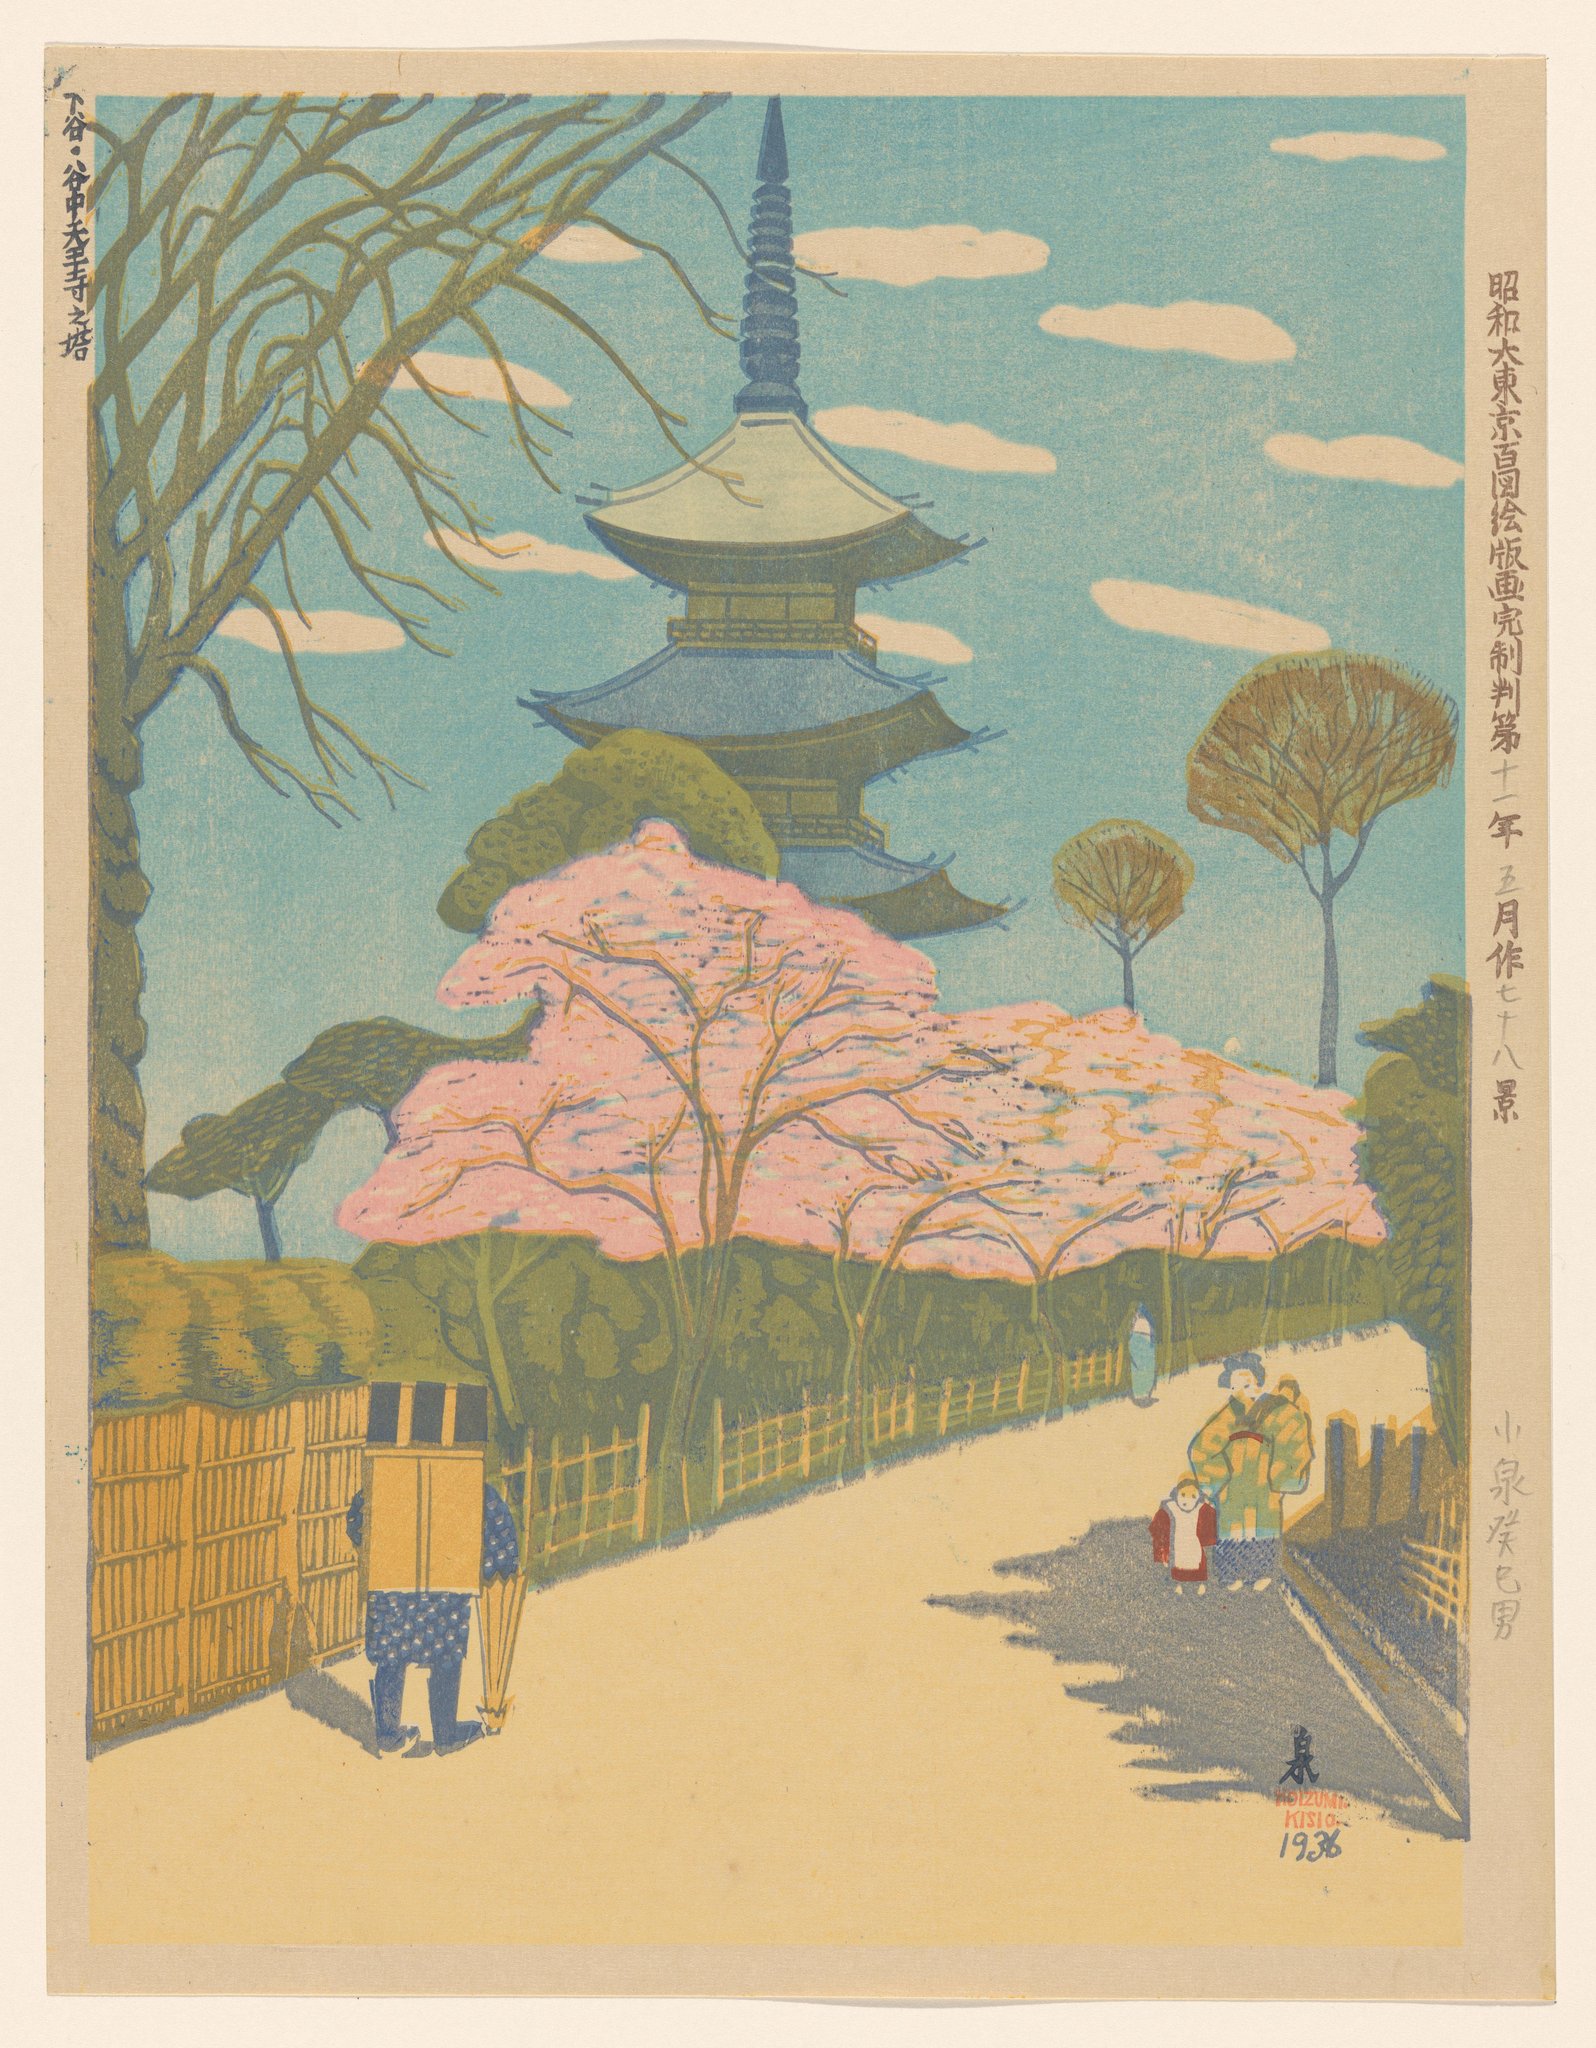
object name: print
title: Shitaya Yanaka Tennōji no tō nanajūhakkei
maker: koizumi kishio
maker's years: 1893-1945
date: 1905-1936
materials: paper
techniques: woodcut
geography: japan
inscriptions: signature: ‘泉’, signature: ‘小泉癸巳男’, seal: ‘Koizumi Kisio.’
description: Op een helderblauwe dag loopt een moeder met haar twee kinderen op het pad langs de Tennō-tempel bij Yanaka in de Shitaya-wijk. Een straatverkoper met handelswaren op zijn rug loopt hen tegemoet. Achter de roze kersenbloesems is de tempelpagode zichtbaar. In september 1928 begon Koizumi Kishio aan zijn ambitieuze plan om honderd landschapsprenten met scènes in Tokyo volledig zelf te ontwerpen, hiervan zelf de drukblokken te snijden en zelf de prenten te drukken. De aanleiding voor het project was grote verandering die Tokyo onderging door de verwoestende Grote Kantō-aardbeving van 1923 en de wederopbouw die daarop volgde. Kishio maakt een bewuste verwijzing naar de bekende serie ‘Honderd beroemde gezichten op Edo’ door Utagawa Hiroshige (1797–1858), met prenten van locaties in Edo—de oude benaming voor Tokyo. Kishio toont overwegend moderne gebouwen, instituten en mensen die de tijdsgeest van de jaren 1920 en 1930 weerspiegelen. Sommige prenten onthullen daarentegen een nostalgische blik op overblijfselen uit het oude Edo. Kishio verkocht de prenten aan de hand van een abonnement met een limiet van vijftig leden, die elke maand een of twee prenten zouden ontvangen. Het project begon met negen abonnementen, maar al na de tweede maand werden meerdere daarvan opgezegd en slechts vier mecenassen bleven lid tot en met de voltooiing van de serie. Hij bracht het honderdste ontwerp uit in 1937. Zijn leermeester Ishii Hakutei schreef een inleiding in 1938 die Kishio verwerkte tot een prent en toevoegde aan de set. Tussen 1939 en 1940 maakte hij nog eens negen extra ontwerpen. Met acht van deze ontwerpen verving hij oudere nummers uit de serie, mogelijk omdat hij niet tevreden was met de composities. Uiteindelijk lukte het Kishio om tien complete sets te verkopen aan de shin hanga-uitgever Watanabe Shōzaburō en liet hiervoor speciale houten dozen maken. Deze prent behoort tot een van die tien sets.